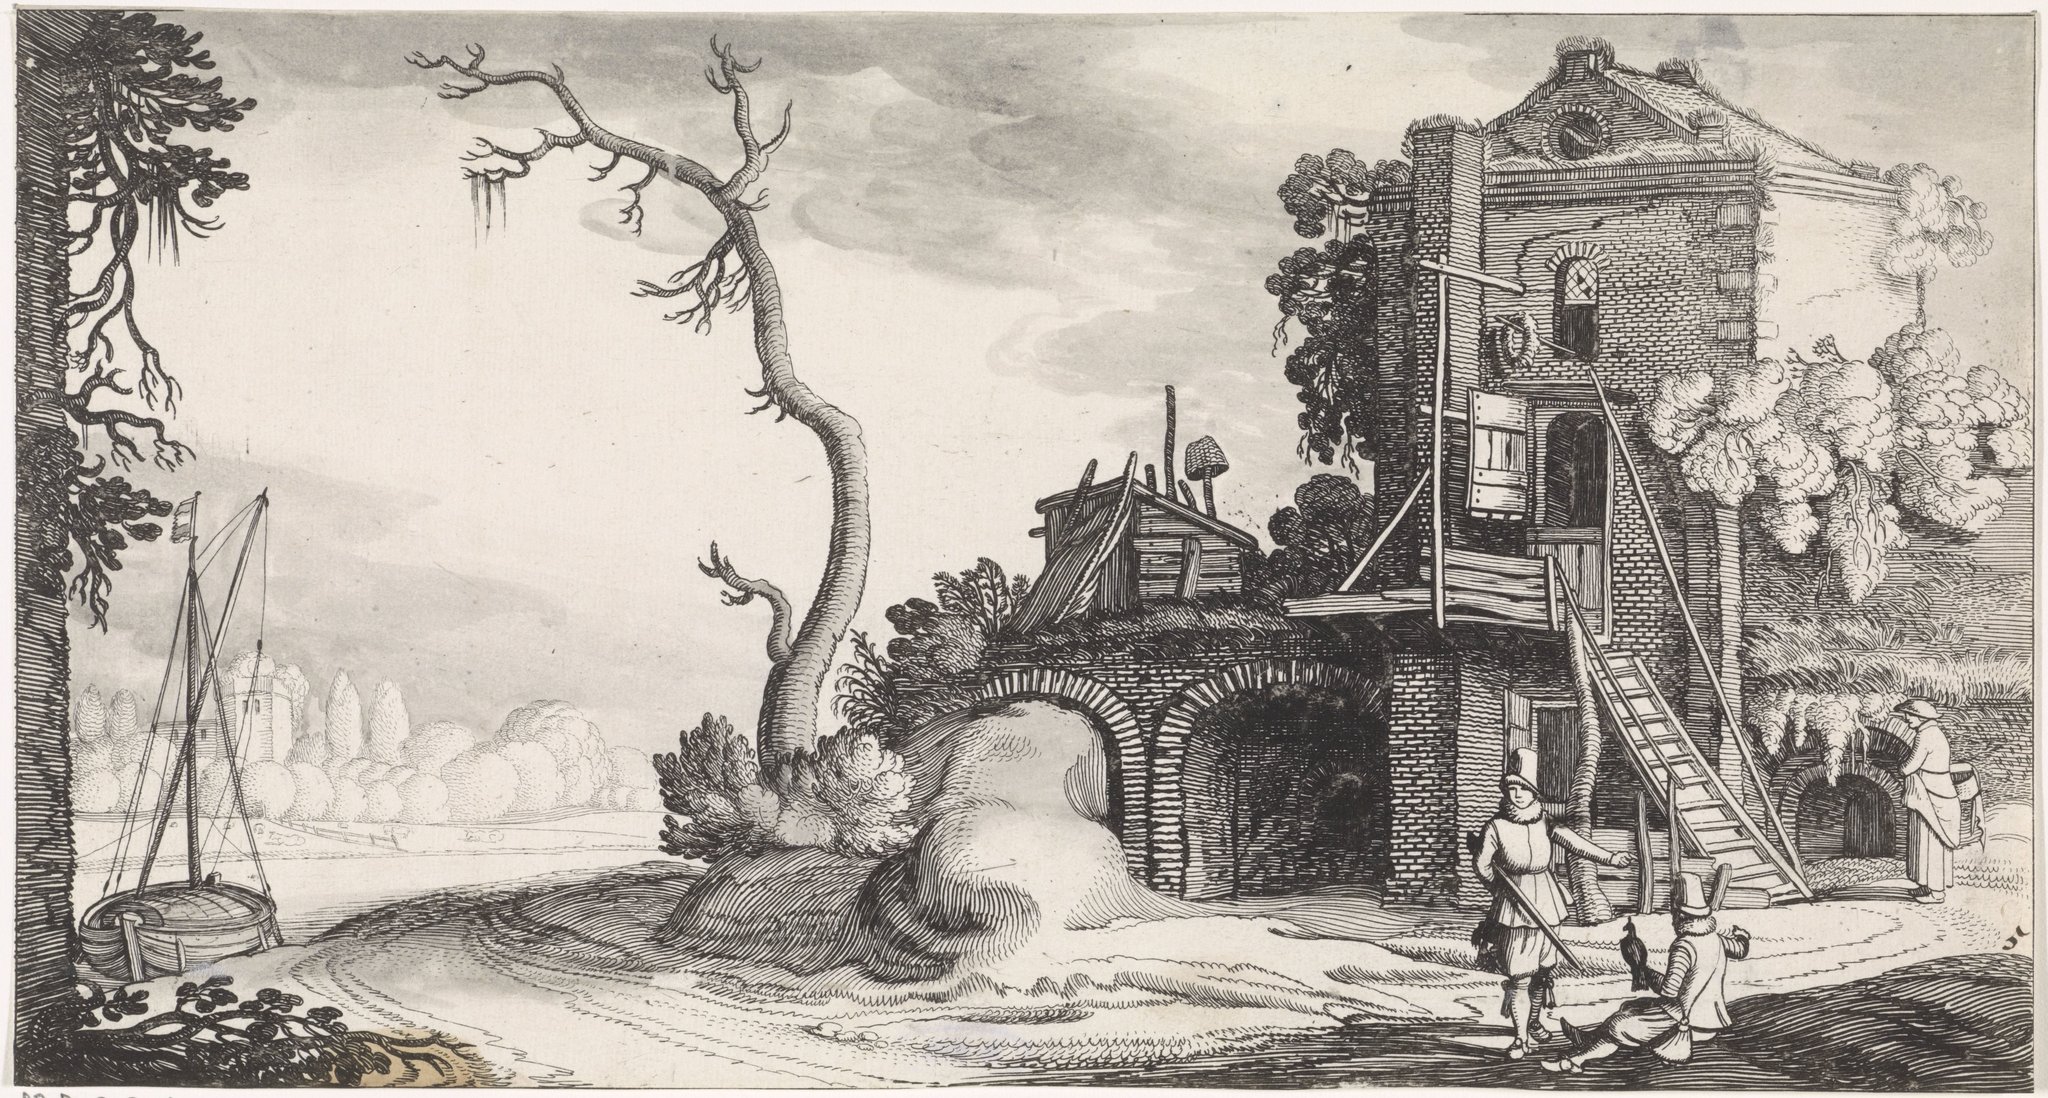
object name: print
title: Playsante lantschappen ende vermakelycke gesichten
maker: jan van de velde (ii)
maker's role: draughtsman, painter, print maker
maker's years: 1593-1641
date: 1639-1641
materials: ink, paper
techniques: brush, etching, pen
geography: northern netherlands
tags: river, sports, games ~ animals (+ hunting with falcon, hawk; falconry), landscape with tower or castle, hotel, hostelry, inn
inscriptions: collector's mark: Lugt 1120, number: ‘5’, collector's mark: Lugt 2228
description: Twee valkeniers bij een toren, gebruikt als herberg, in een rivierlandschap. Vijfde prent van een serie met 36 prenten van landschappen, verdeeld over zes delen.